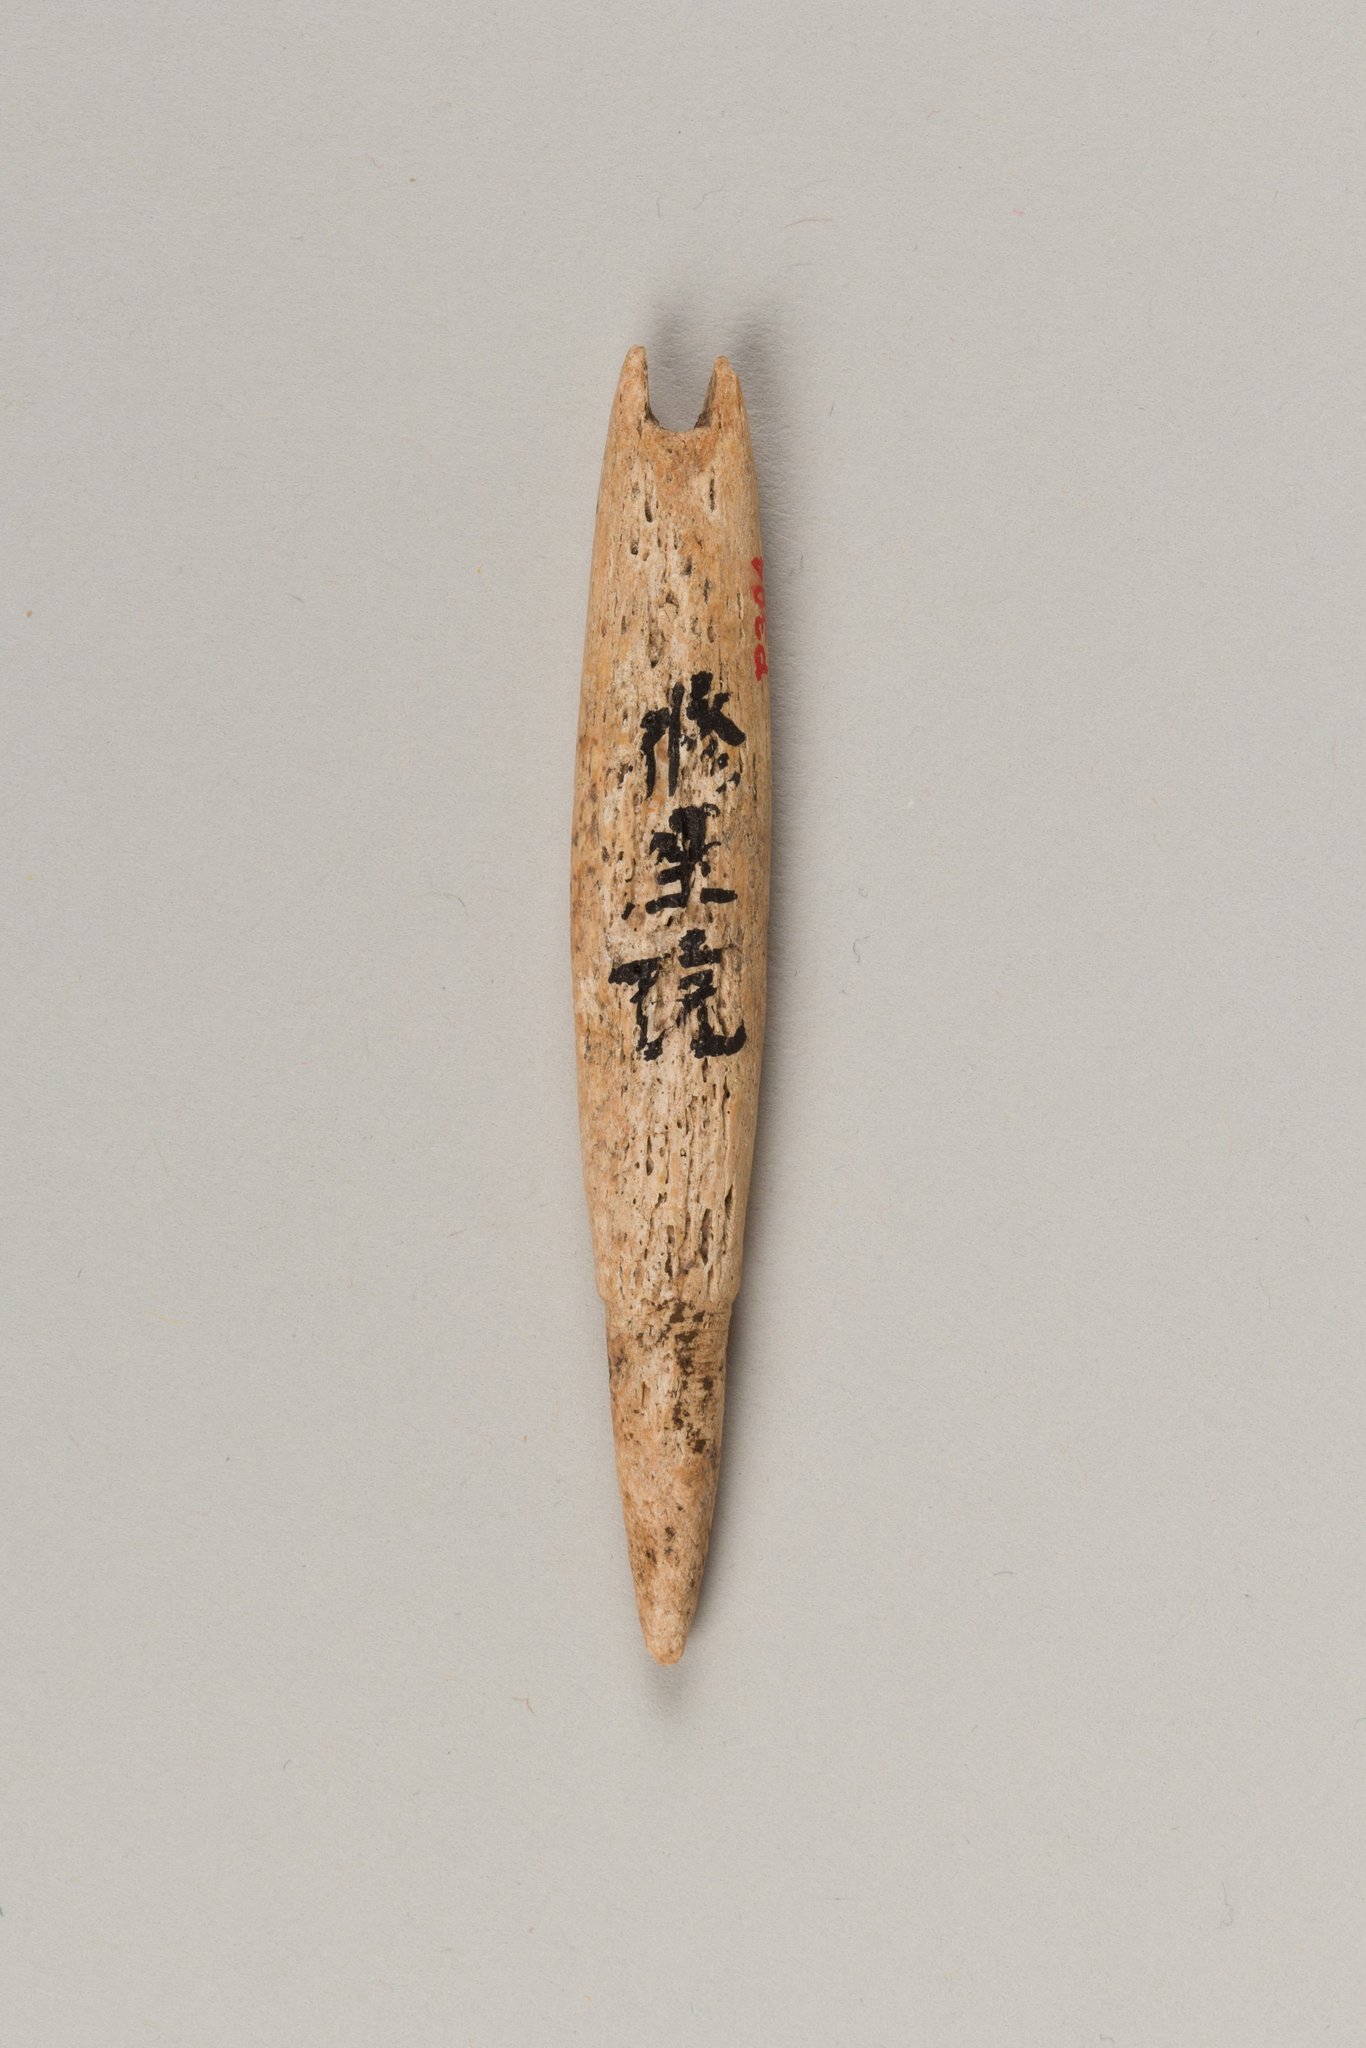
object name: harpoon head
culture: japanese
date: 1000-300 BCE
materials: bone